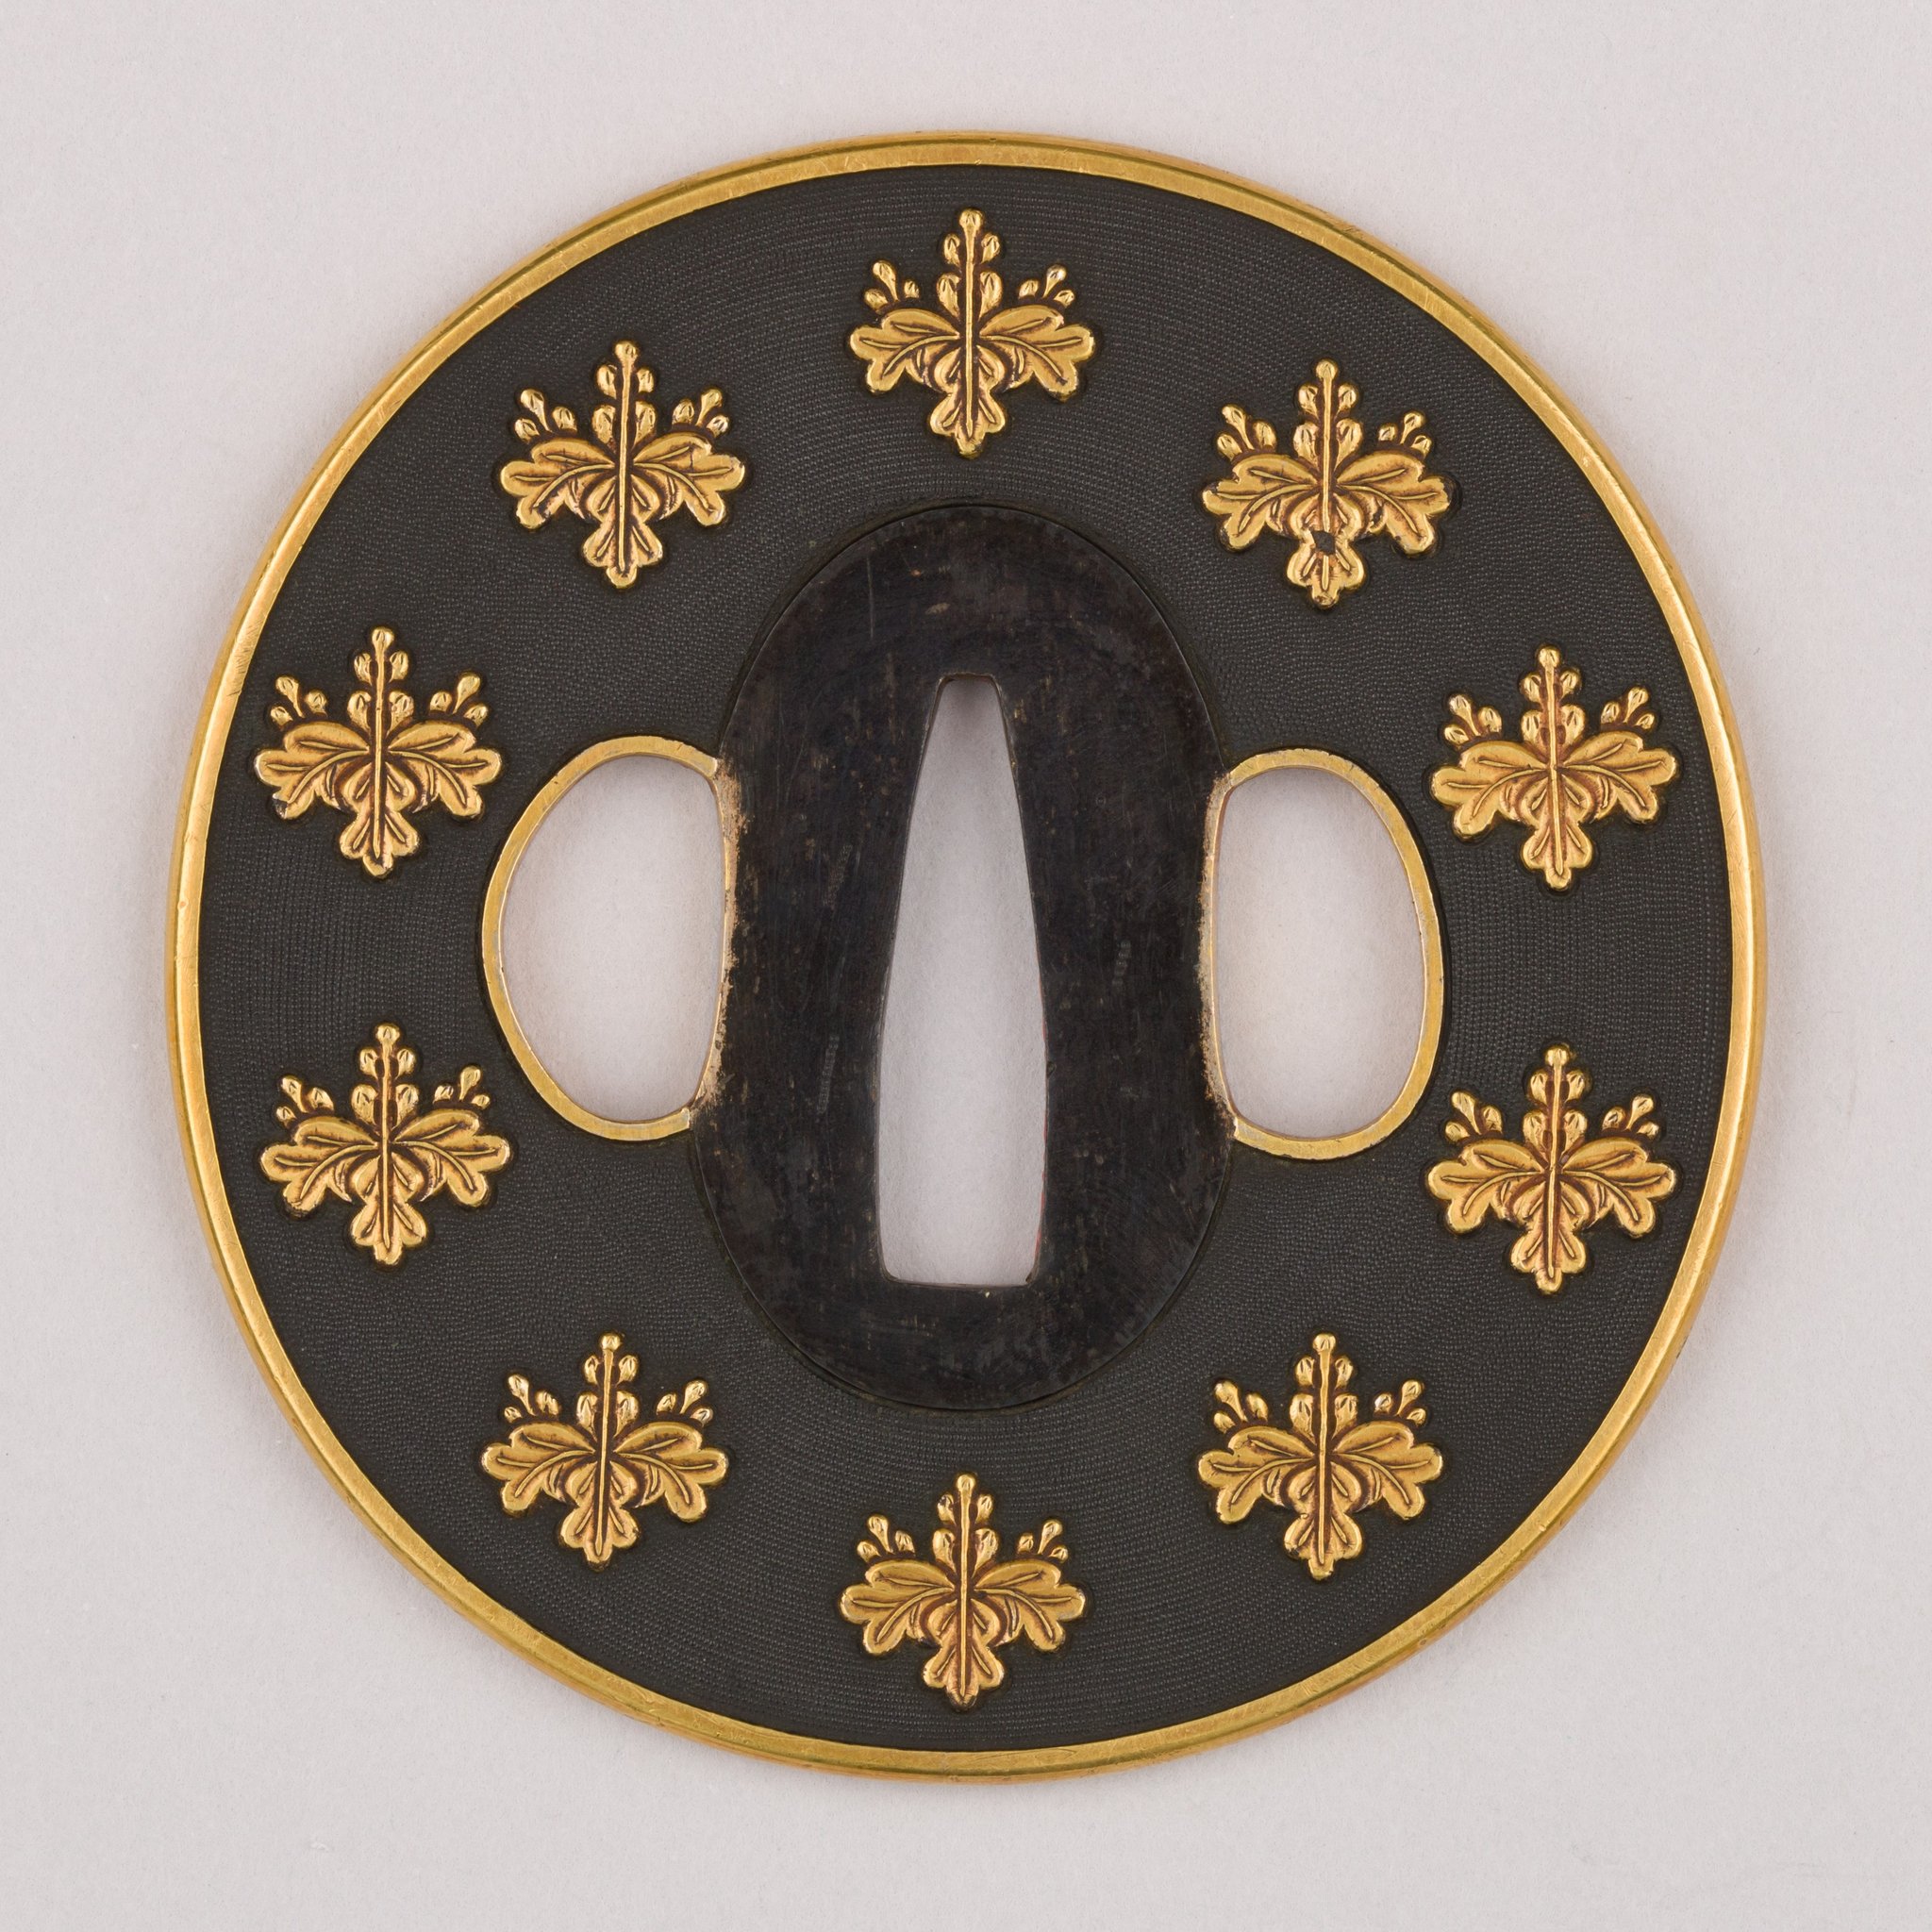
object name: sword guard tsuba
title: Sword Guard (Tsuba)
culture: japanese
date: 1567-1633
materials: copper, gold alloy, gold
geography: japan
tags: flowers